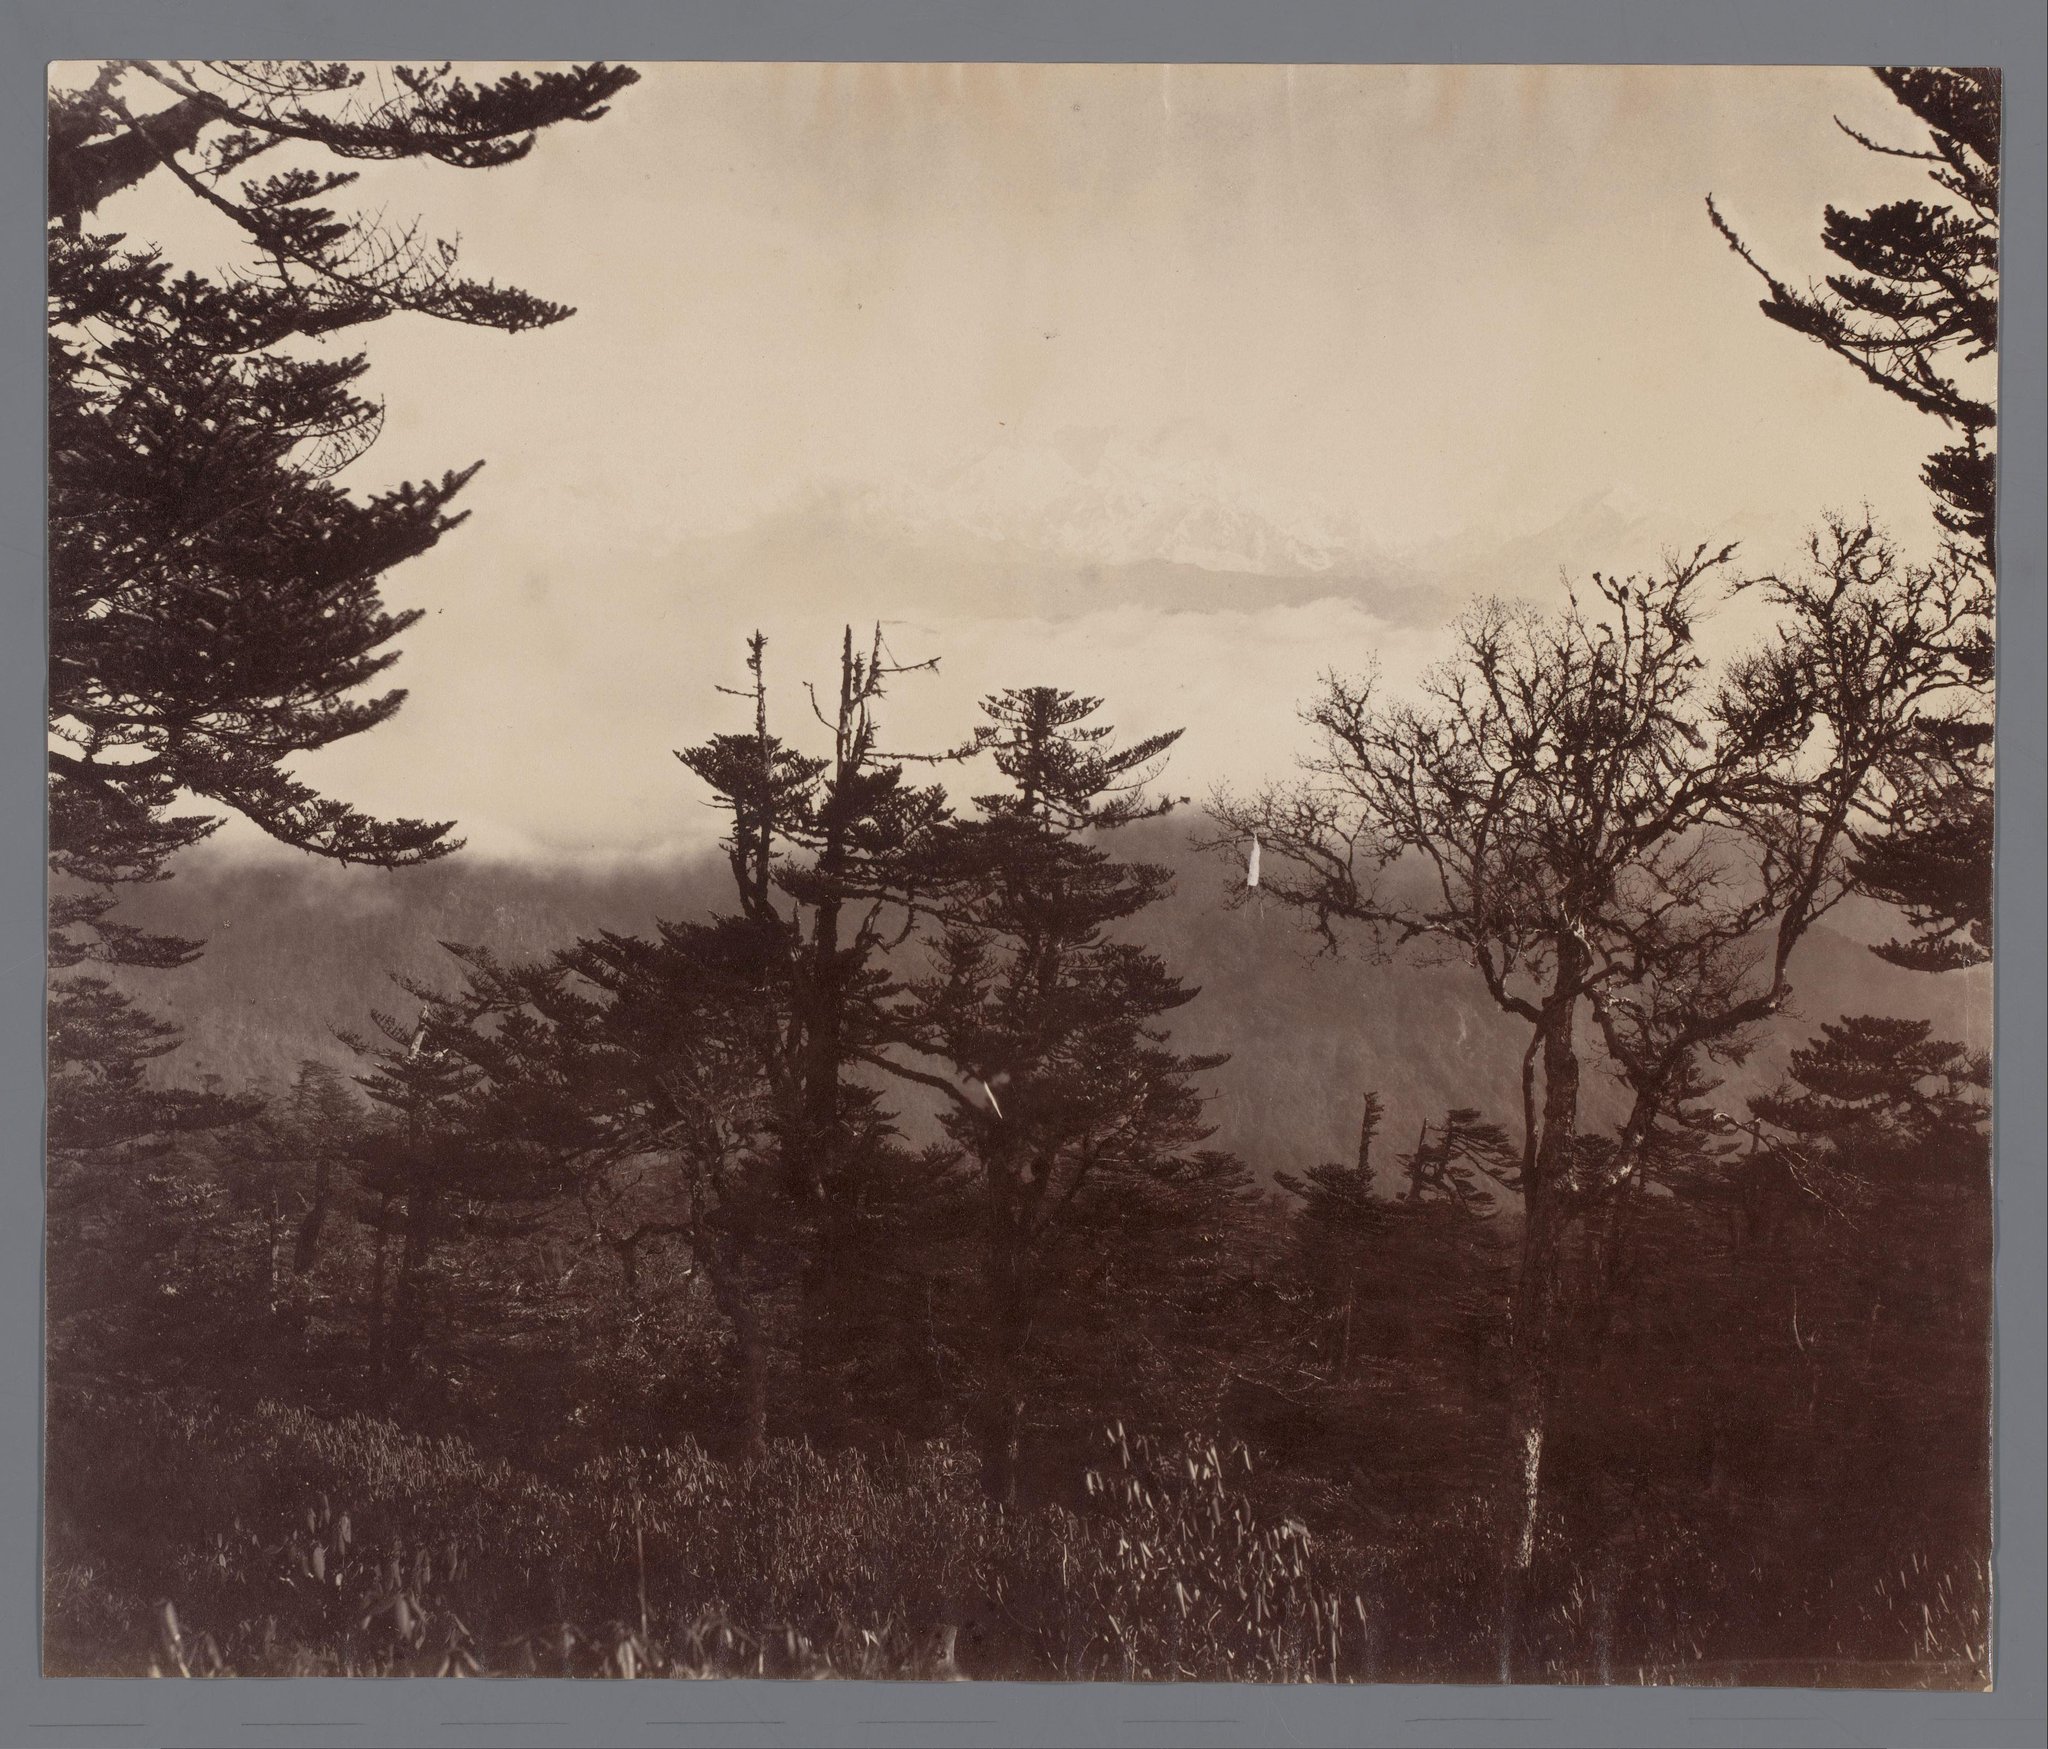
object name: photograph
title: Landschap met dennenbomen en besneewde bergen op de achtergrond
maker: Anonymous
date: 1880-1900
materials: paper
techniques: albumen print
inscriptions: inscription: ‘B’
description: Landschap met dennenbomen en besneewde bergen op de achtergrond.